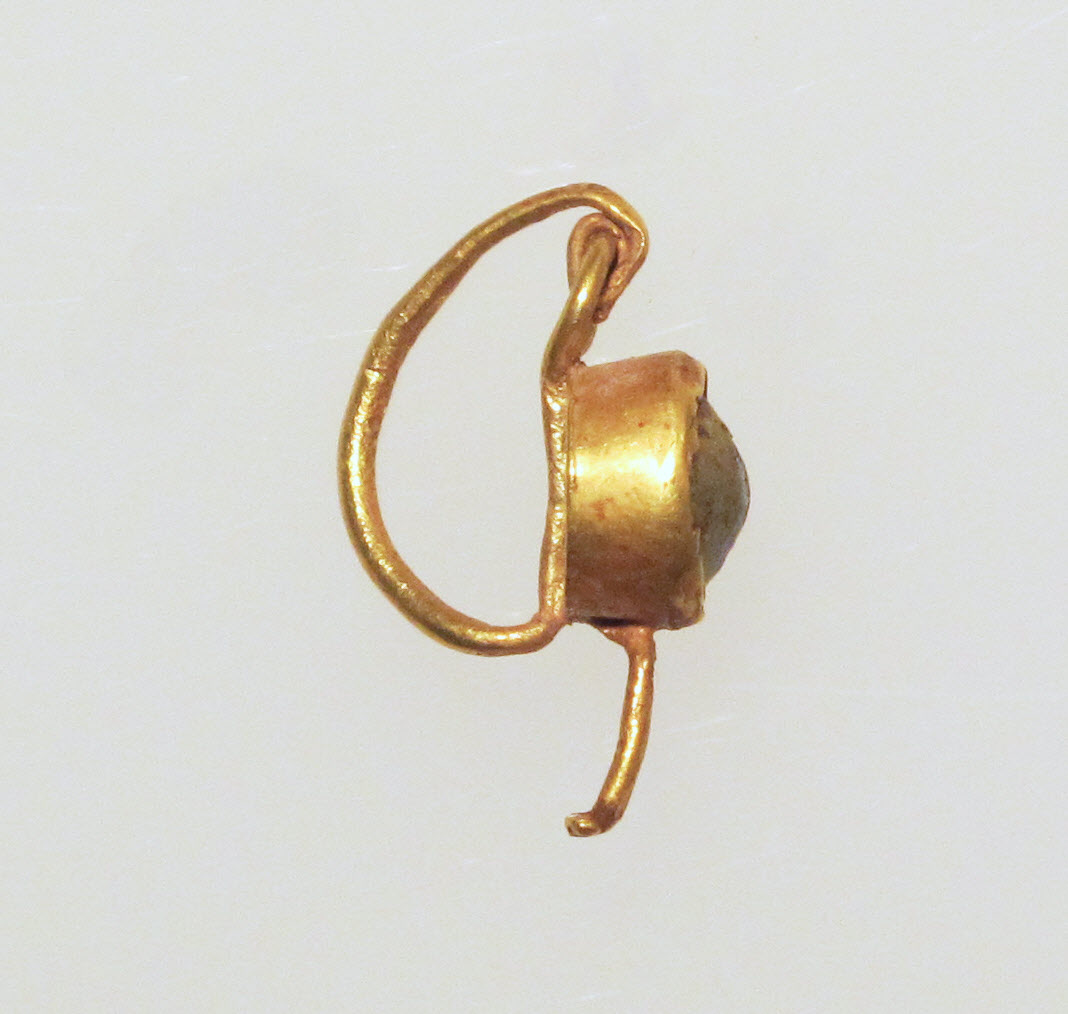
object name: earring with paste setting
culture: roman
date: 1-300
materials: glass, gold, paste